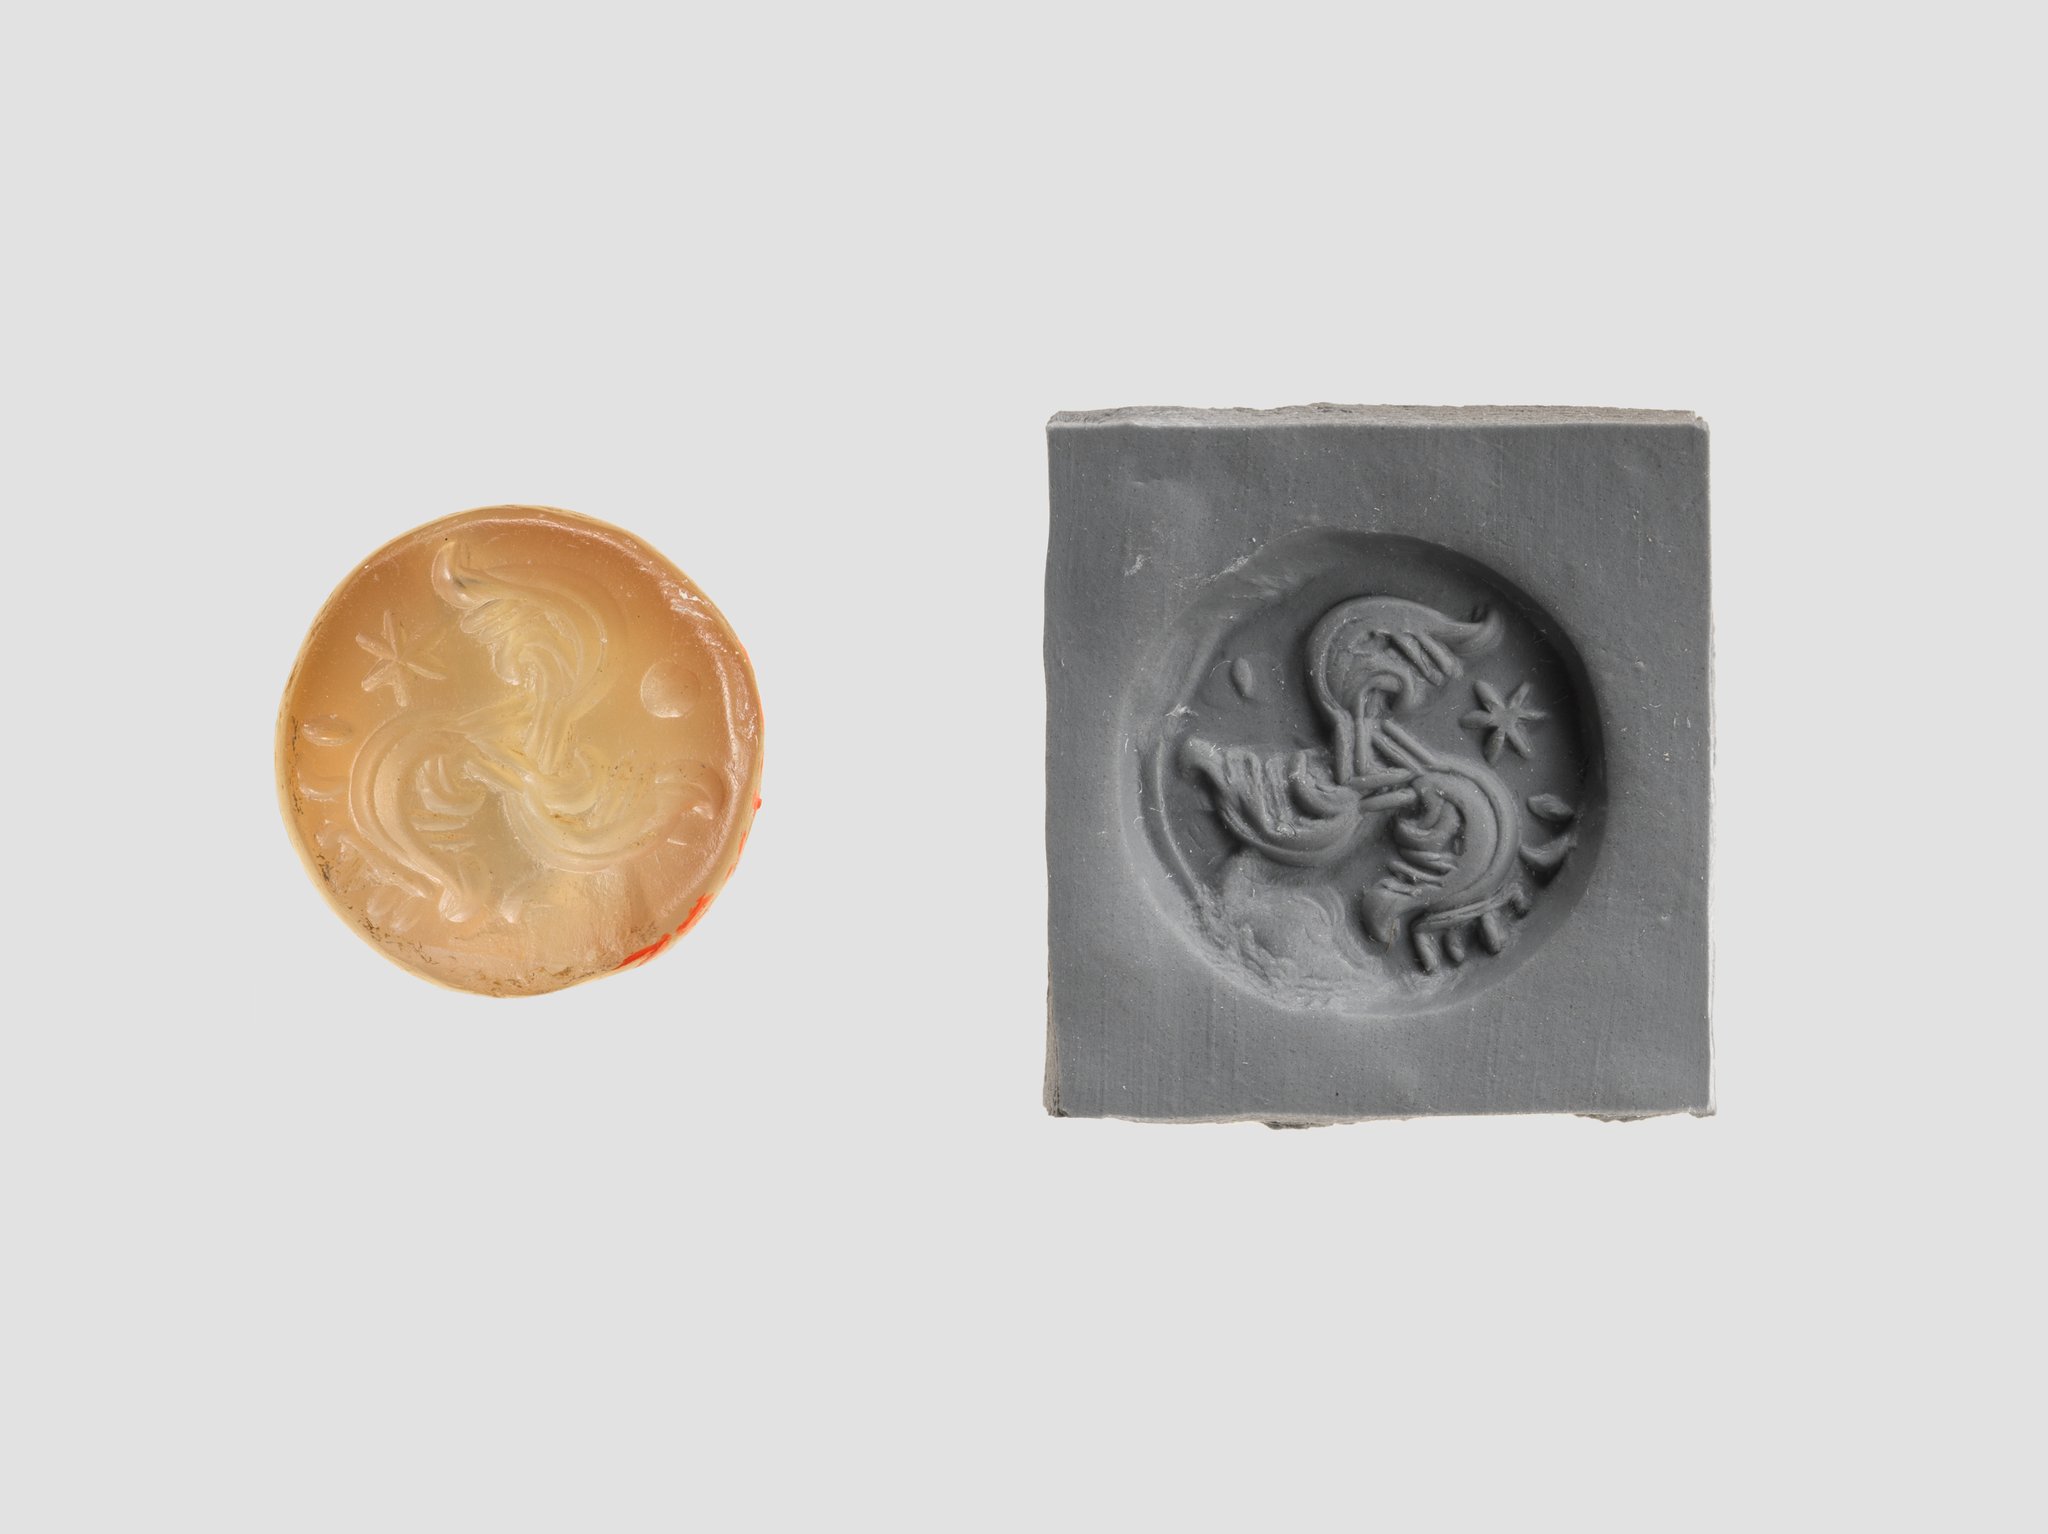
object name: stamp seal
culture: sasanian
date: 201-700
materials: stone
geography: iran or mesopotamia